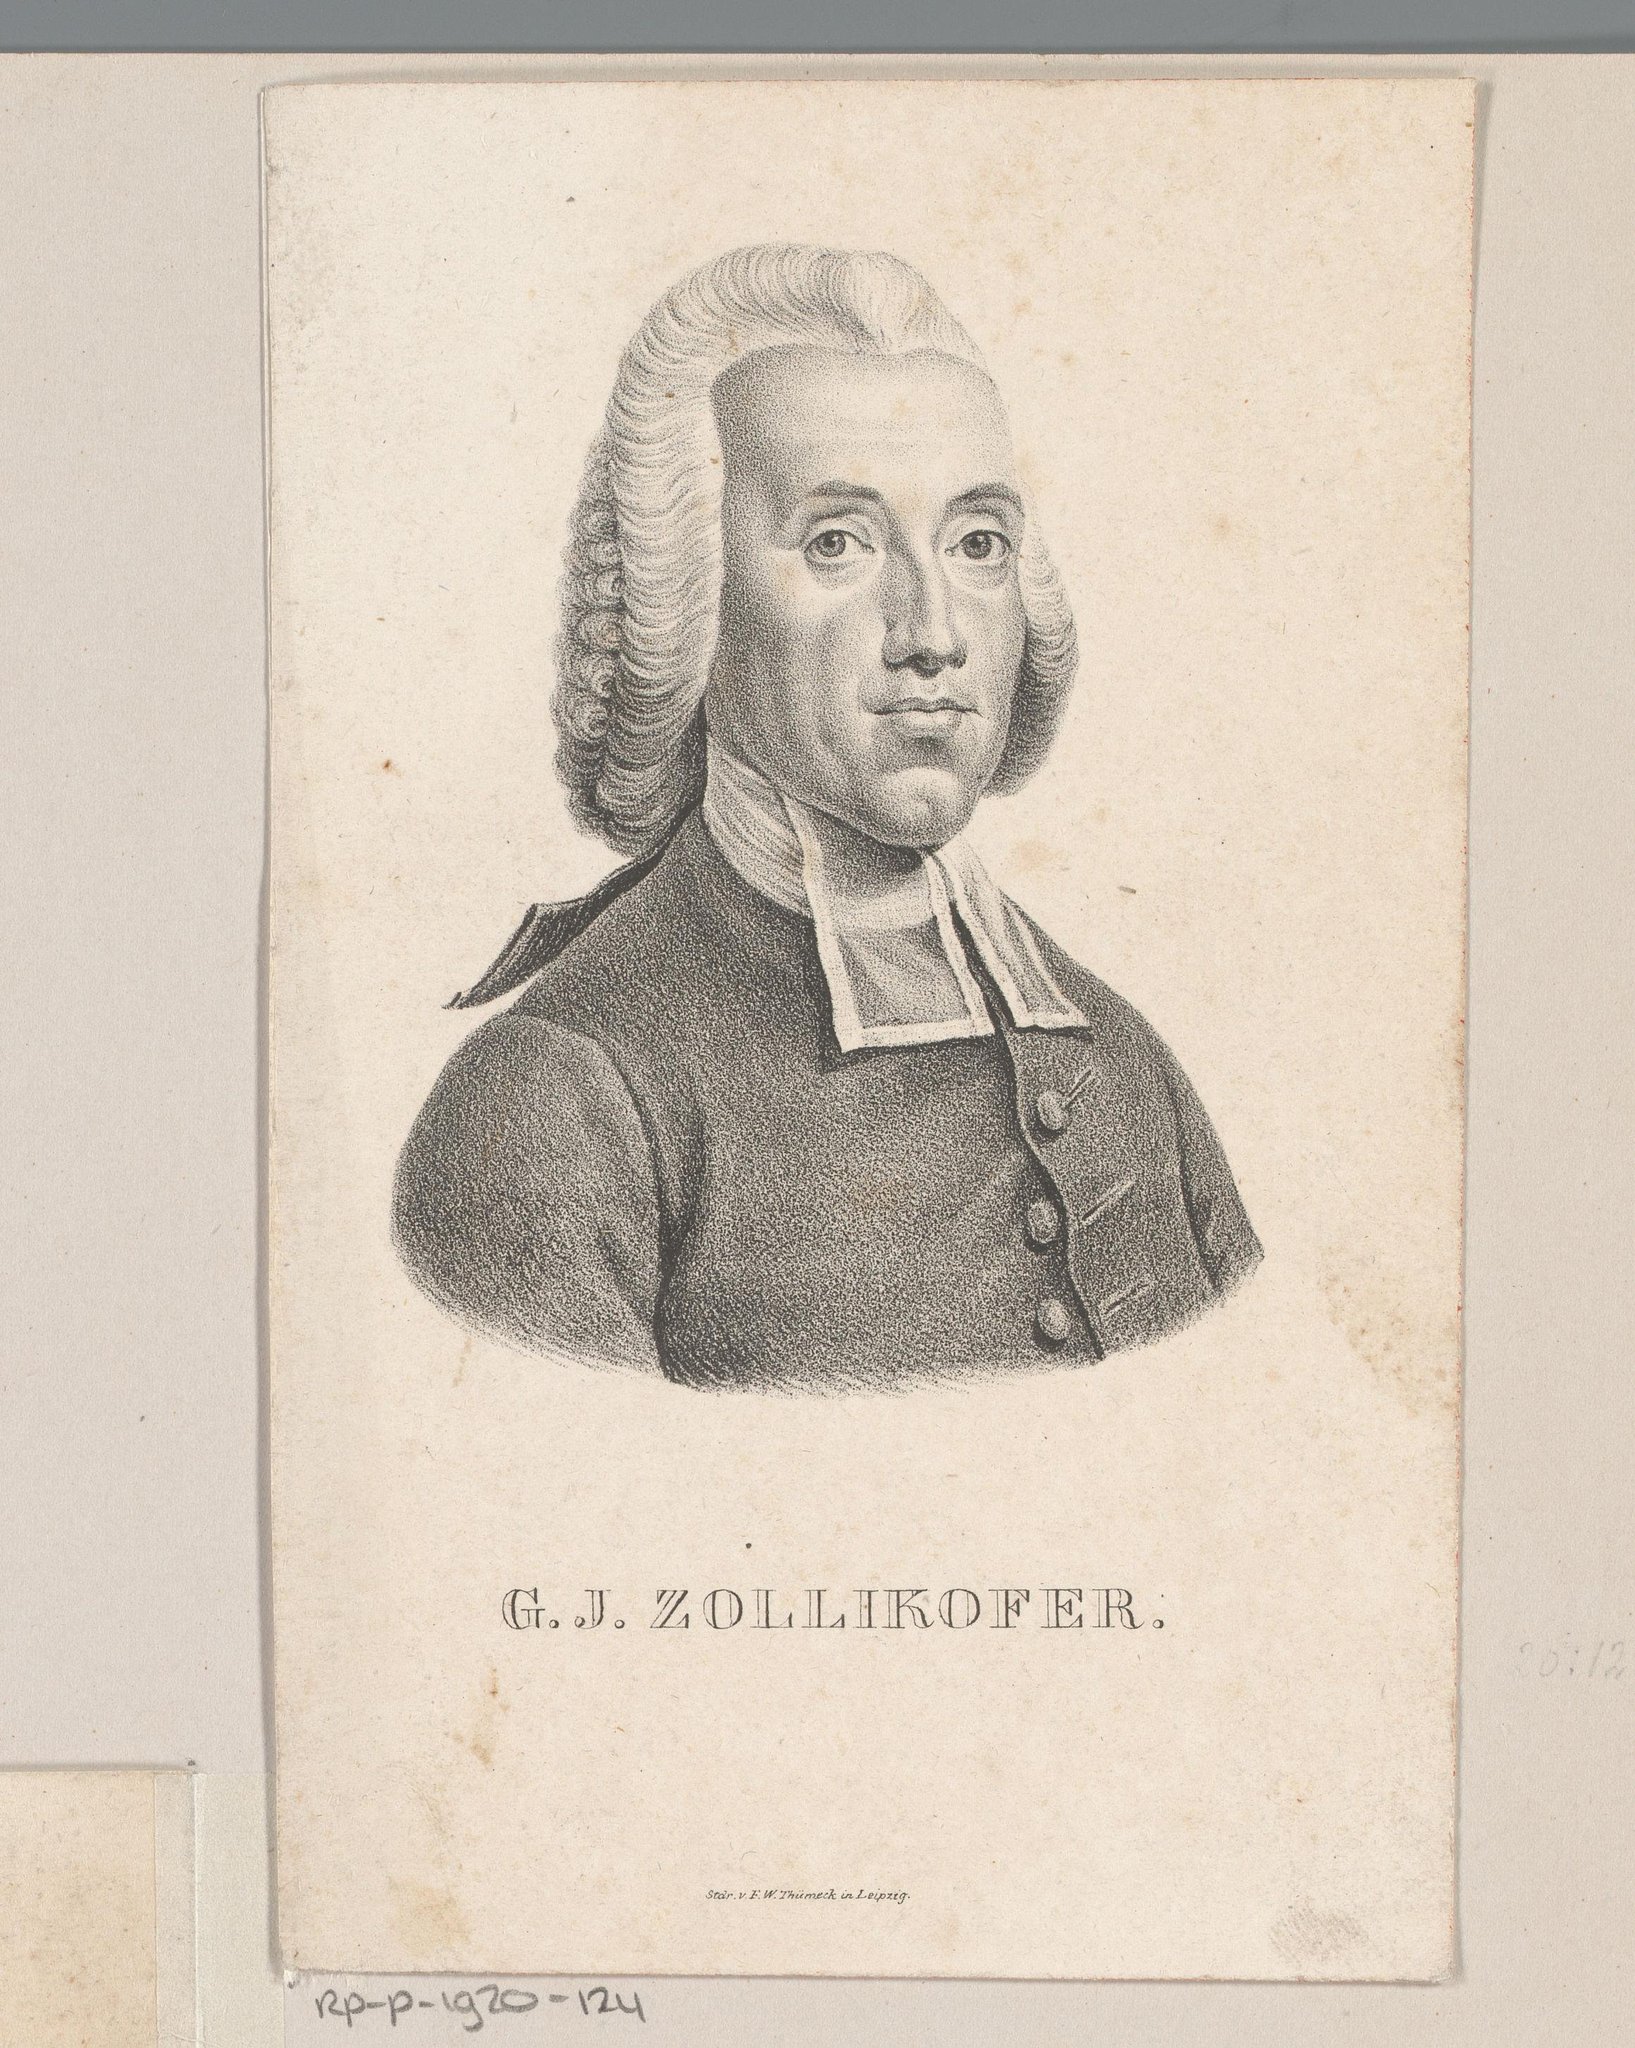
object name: print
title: Portret van Georg Joachim Zollikofer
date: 1801-1829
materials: paper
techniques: lithograph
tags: historical persons, functionaries and dignitaries ~ protestant churches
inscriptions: collector's mark: Lugt 2228